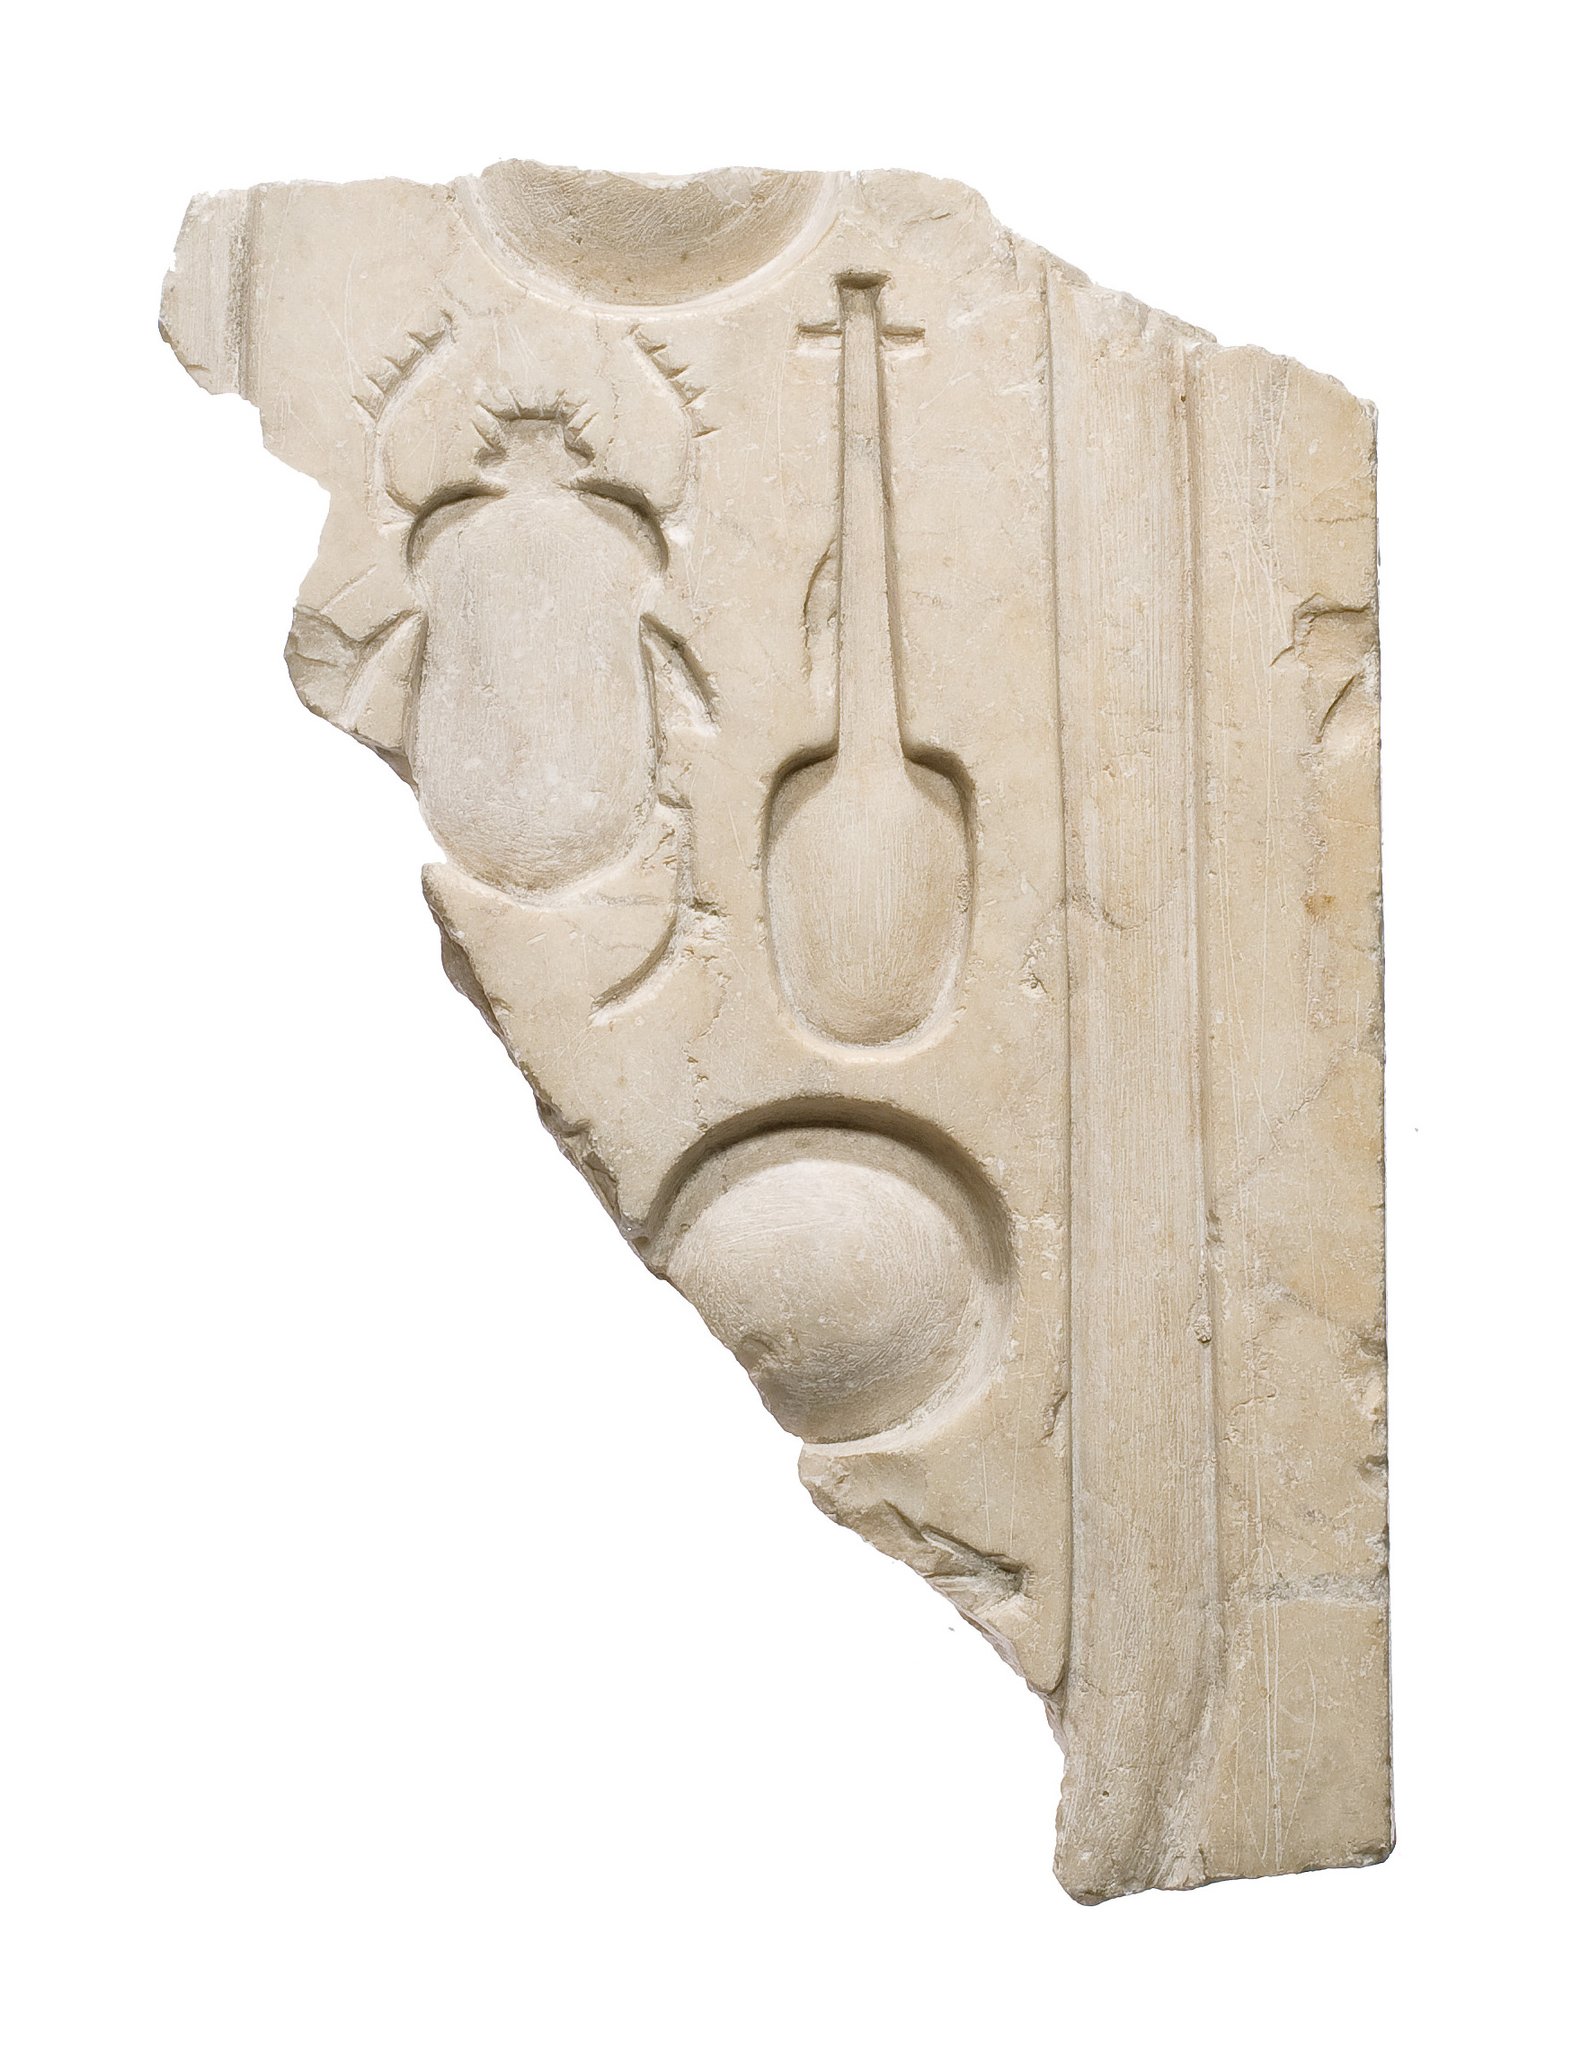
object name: inscribed element, akhenaten cartouche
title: Inscribed element, Akhenaten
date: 1353-1336 BCE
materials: limestone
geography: egypt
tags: hieroglyphs